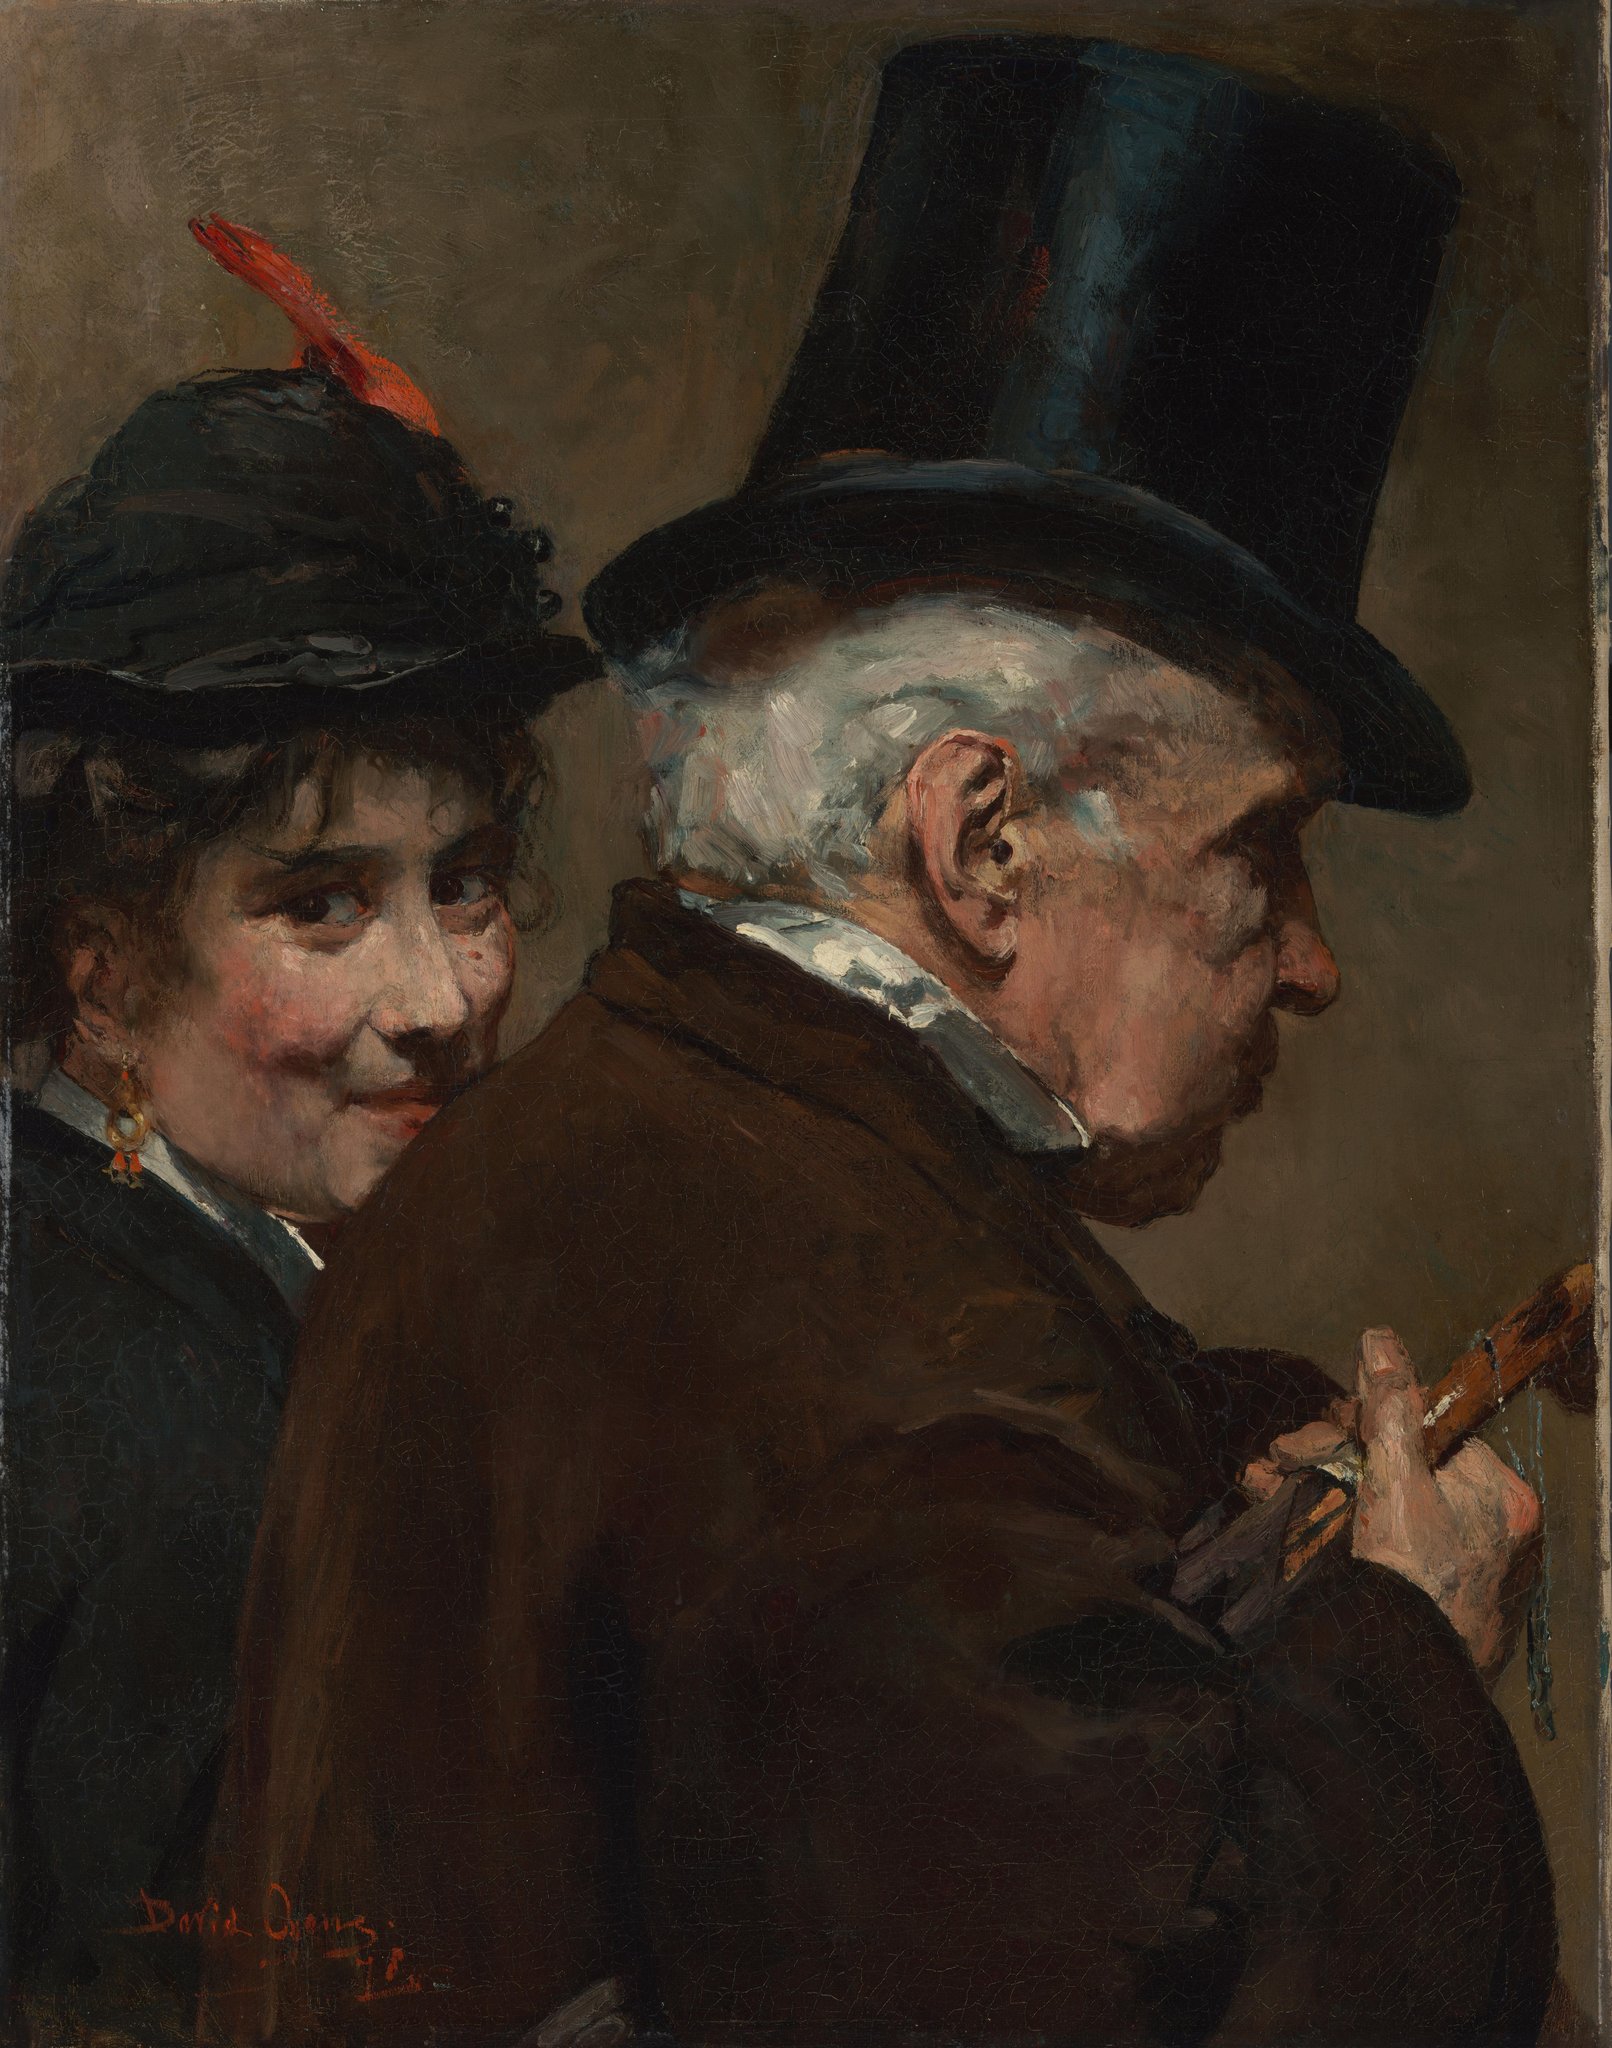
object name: painting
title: Père et fille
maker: david oyens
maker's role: draughtsman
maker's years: 1842-1902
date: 1878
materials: canvas, oil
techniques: brush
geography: brussels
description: Dit schilderij toont een tweetal passanten op straat. De voorste is een man met grijs haar, een hoge hoed dragend terwijl hij in zijn rechterhand een paraplu vasthoudt. Schuin naast hem loopt een jonge vrouw die de kijker over haar schouder met een glimlachende blik recht aankijkt. in haar oren draagt zij gouden hangers. ze draagt een zwart hoedje met een rode veer. Dit schilderij is een beeldvertaling van het boek 'La Nabab' door Alphonse Daudet, dat in 1878 net uit was. Oyens was er zozeer door gegrepen dat hij er zijn eigen versie van maakte. Het kunstwerk, uit Oyens’ beste tijd, is een van de mooiste voorbeelden van zijn werk. Daarbij komt dat we behalve een klein portretje van Pieter geen werk van de tweeling hen in huis hebben. Ook de band met Brussel – waar toch de nodige Nederlanders woonden en werkten – is weinig zichtbaar. Wat vooral opvalt is de gedurfde uitsnijding, een snapshot. We kennen dit natuurlijk van Breitner uit de tweede helft van de jaren 1880, maar in 1878 was dit nog ongebruikelijk in Nederland en België. Oyens streven was om iets moderns te creëren, mede geïnspireerd door de ideeën van Baudelaire en Courbet die warden verkondigd in nieuw opgerichte kunsttijdschriften zoals L’art Libre en L’Art Universel. Men moest l’âme van de mens weergeven tegen de moderne tijd. Om tot goede modern kunst te komen moest je sincere zijn, dat wil zeggen een eerlijke en precieze weergave geven van de omgeving.